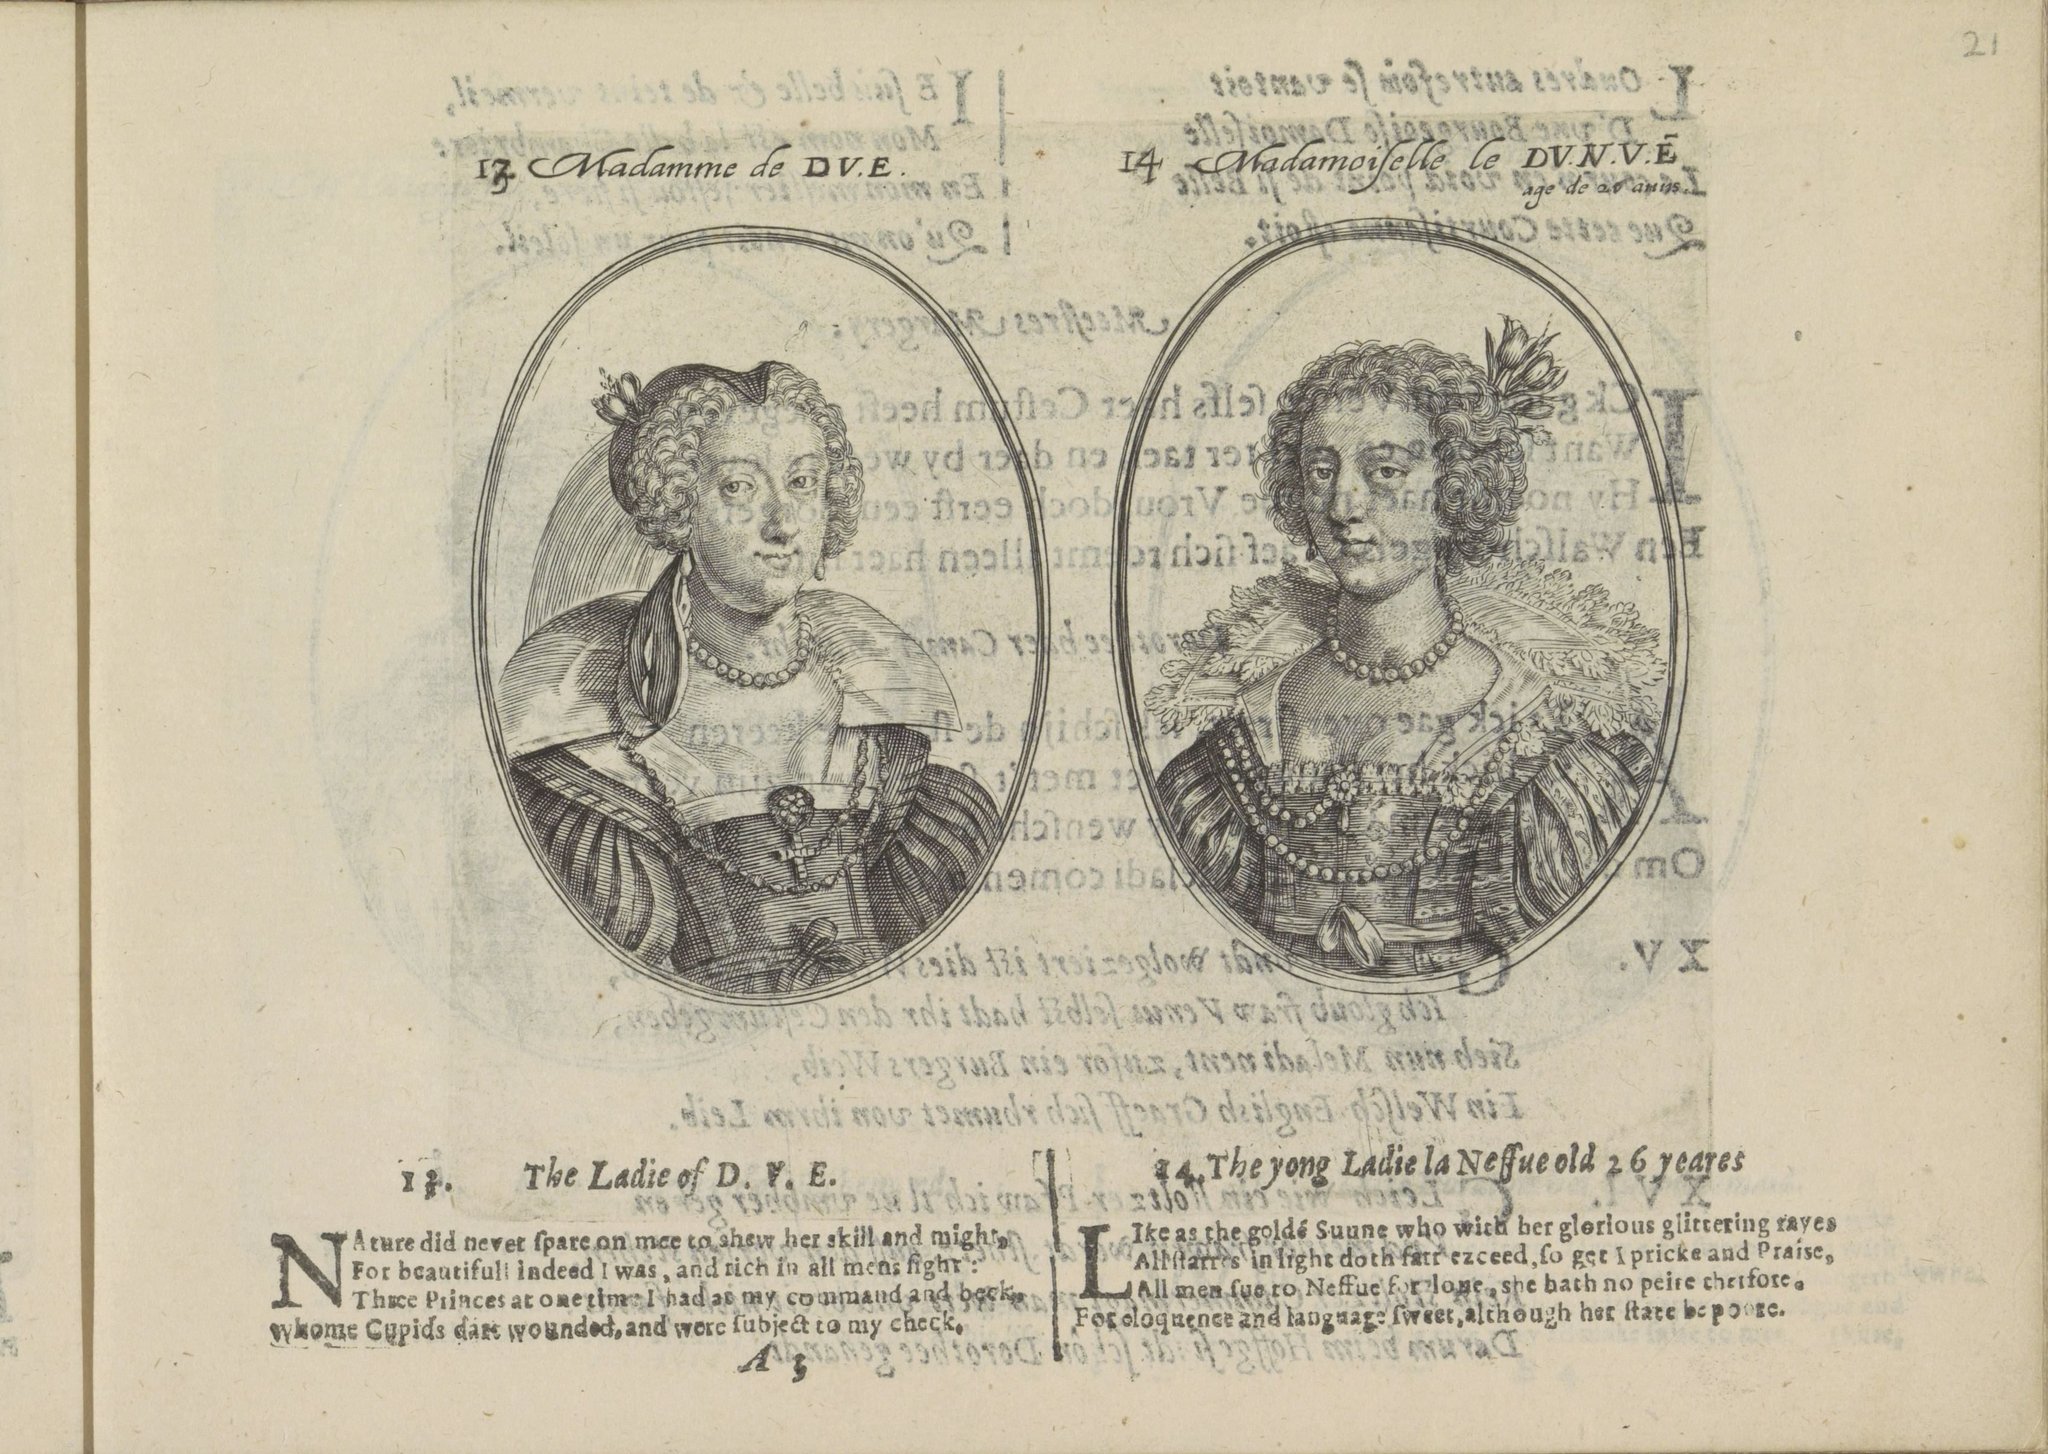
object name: album leaf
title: Miroir des plus belles courtisanes de ce temps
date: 1635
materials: paper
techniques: engraving, letterpress printing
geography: utrecht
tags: herding, herdsman, herdswoman, shepherd, shepherdess, cowherd, etc.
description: Twee voorstellingen op een albumblad. Links de courtisane Madamme van D.V.E. en rechts Mademoiselle le DV.N.V.E. (La Neffue) op de leeftijd van twintig jaar. Bovenaan genummerd: 13 en 14, voorheen 17 en 18. Daaronder twee kwatrijnen in het Engels. Het blad maakt deel uit van een album.